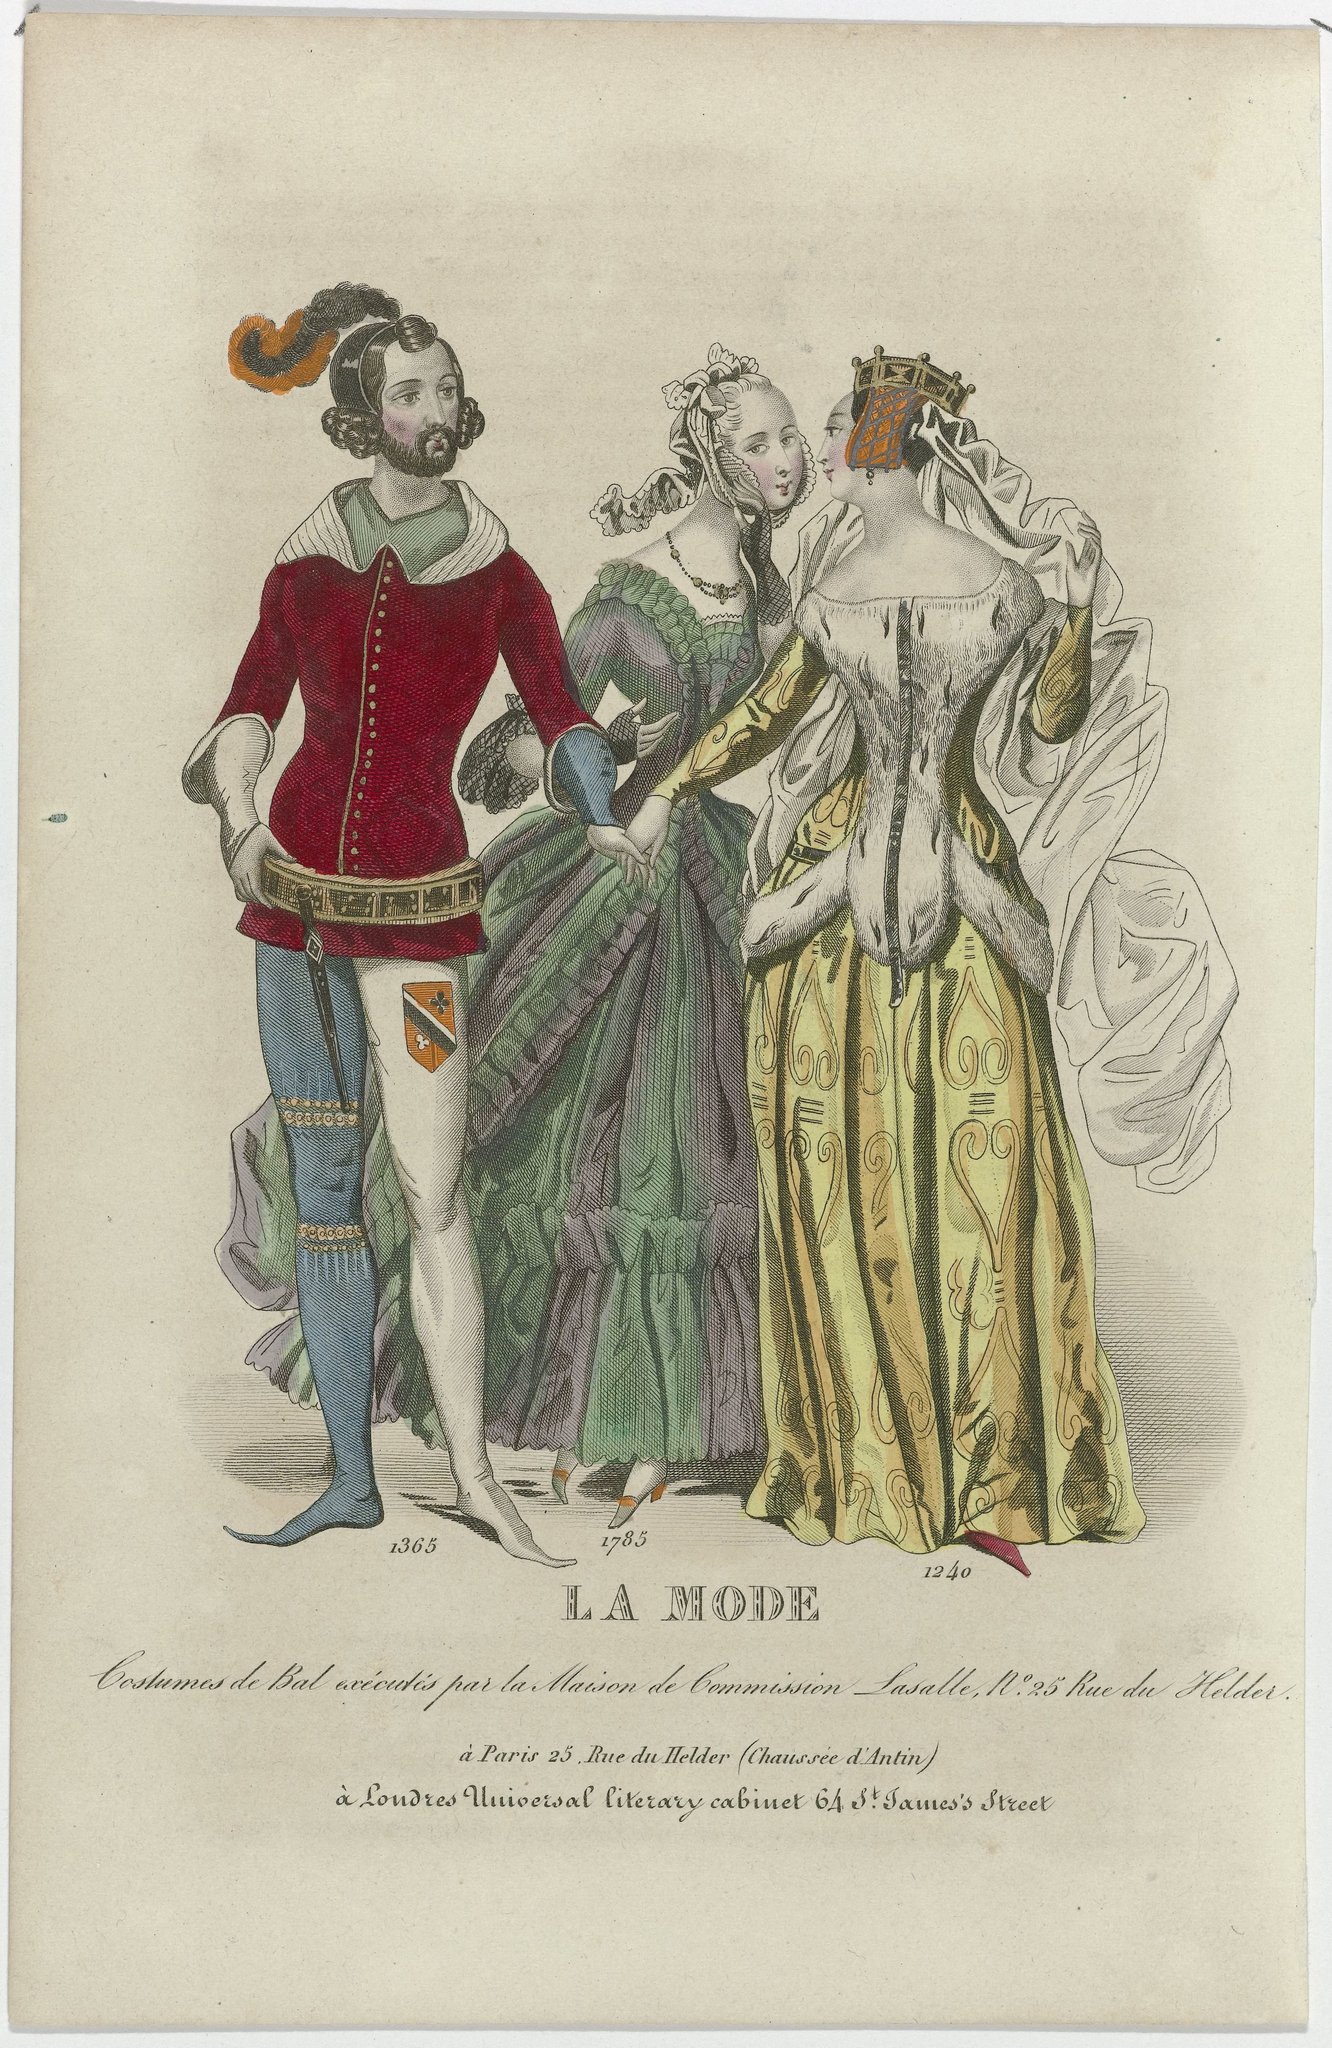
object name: fashion print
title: La Mode, ca. 1839, : Costumes de Bal exécutés (...)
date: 1839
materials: paper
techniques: engraving, hand coloring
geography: paris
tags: historical costume (+ men's clothes), historical costume (+ women's clothes), fashion plates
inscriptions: address: ‘à Paris 25, Rue du Helder (Chaussée d'Antin) / à Londres Universal literary cabinet 64 St. James's Street’, caption: ‘Costumes de Bal exécutés par la maison de Commission Lasalle, No. 25 Rue du Helder.’, title: ‘La mode’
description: Man en twee vrouwen in verkleedkleren (travesti), gebaseerd op historische kostuums uit 1365, 1785 en 1240. Volgens het onderschrift: 'Costumes de Bal', uitgevoerd door 'la Maison de Commission Lasalle'. 'Travestissements'. Prent uit het modetijdschrift La Mode (1829-1855).